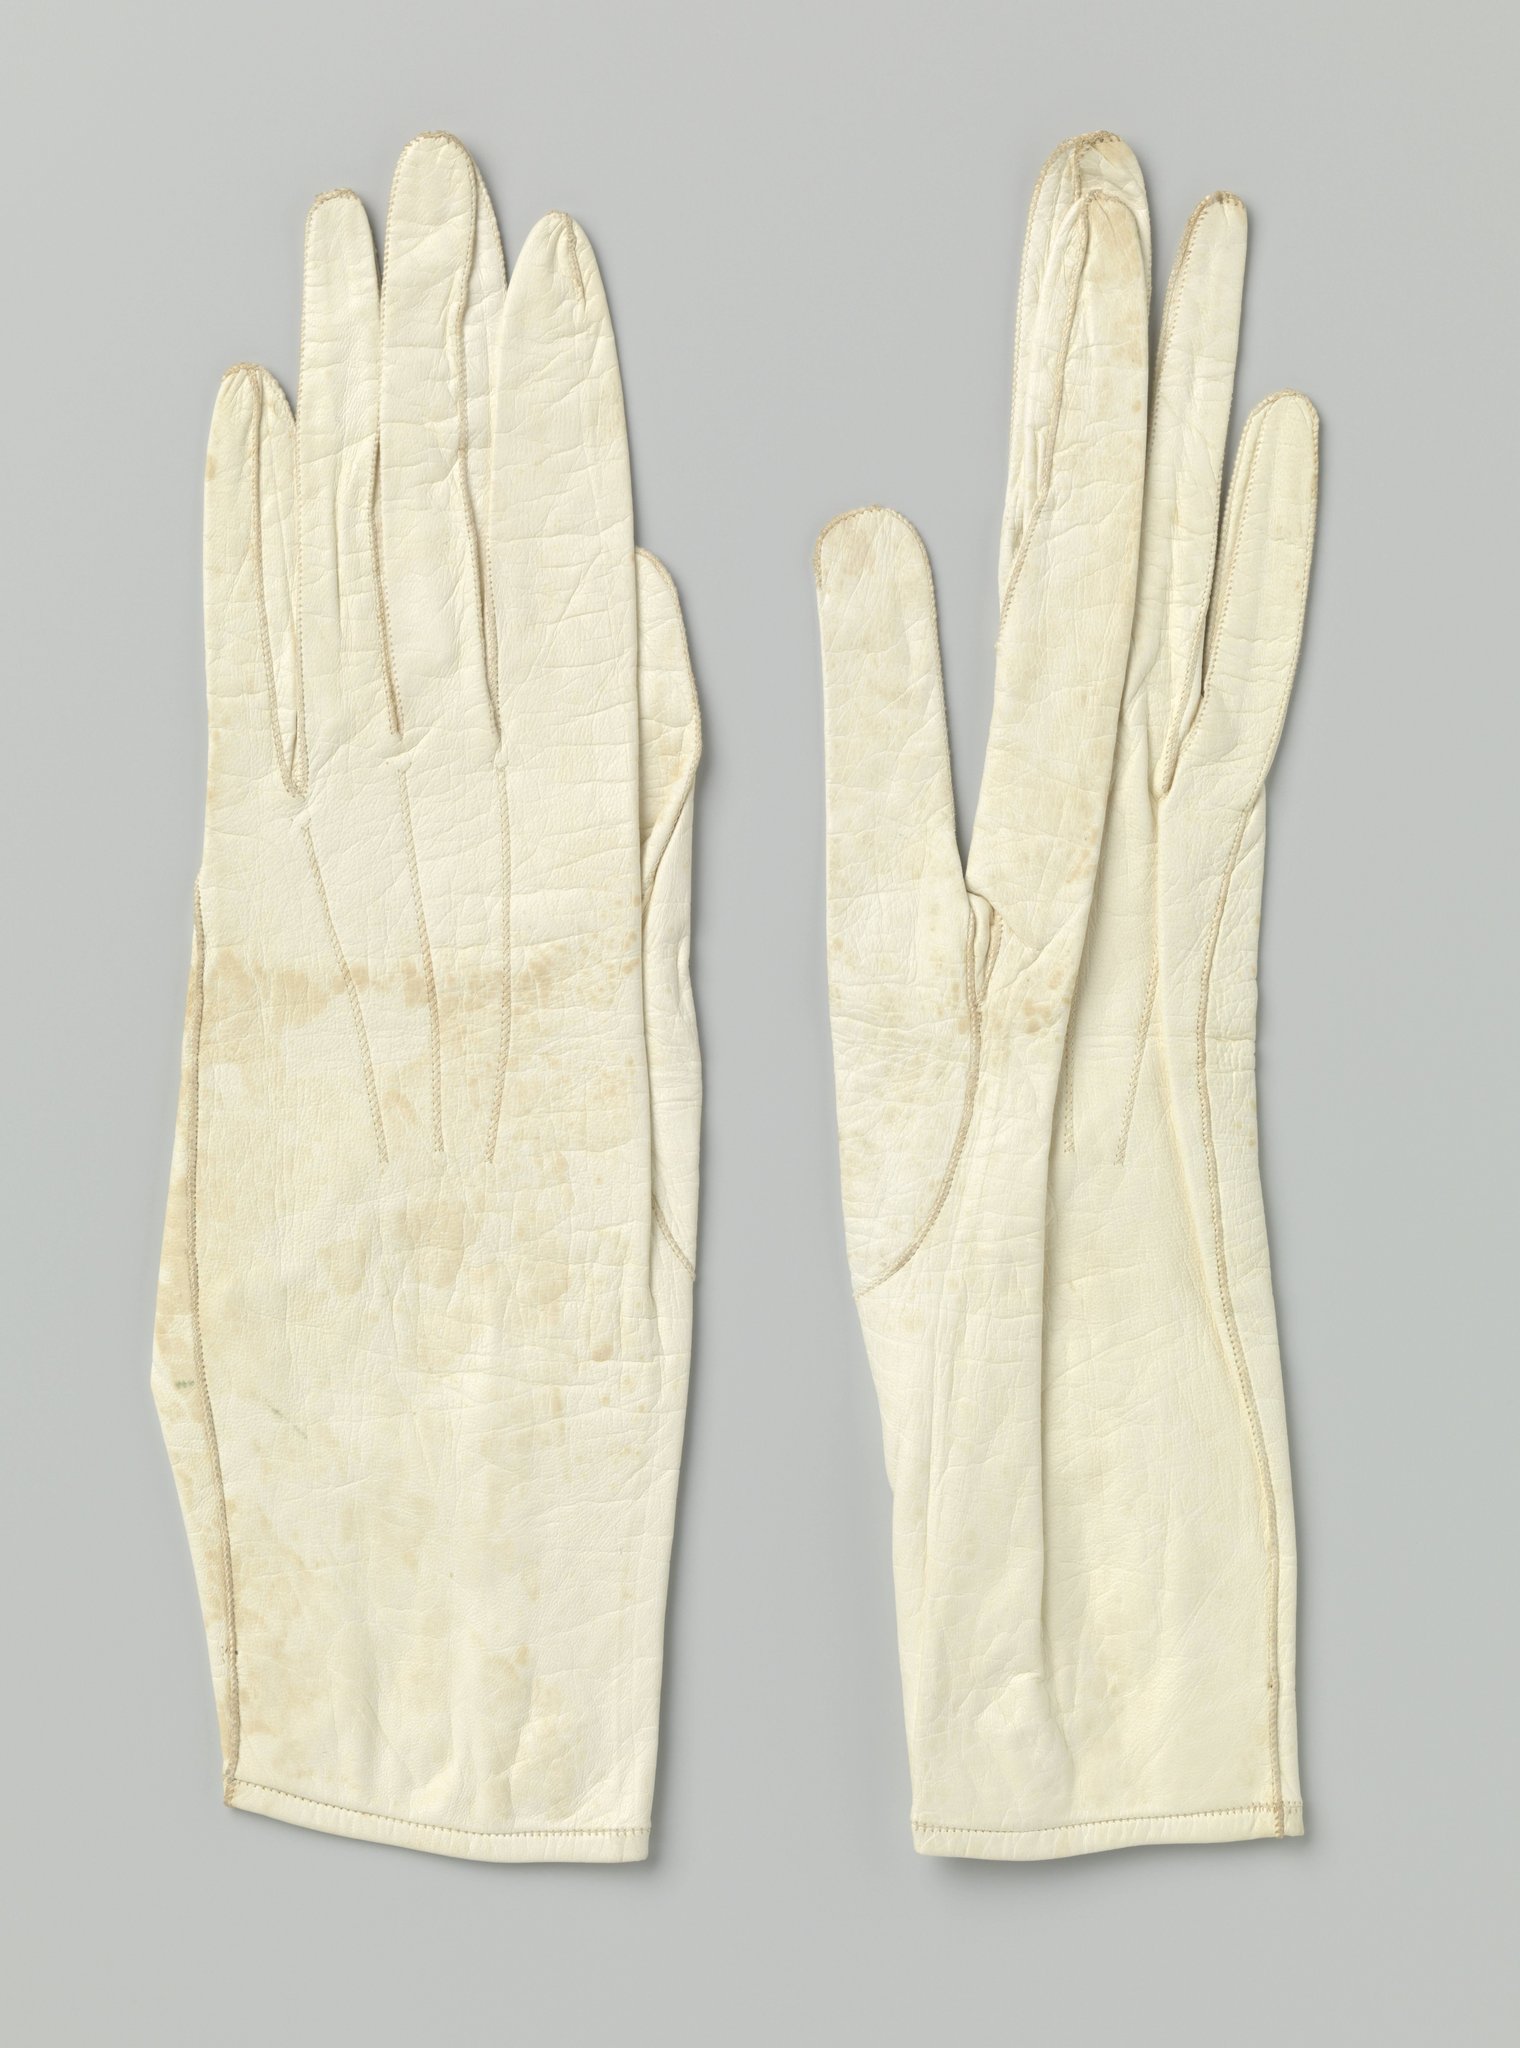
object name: womenswear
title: Handschoen van glacéleer, kort model, sluiting met drie knopen van parelmoer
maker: m. laimböck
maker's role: modehuis, modewarenhuis, modewinkel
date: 1900-1925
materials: mother of pearl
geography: netherlands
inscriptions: stamp: ‘tekst’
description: Linker handschoen van glacéleer. Bij de pols een split met drie parelmoeren knoopjes. Op de hand drie gestikte lijnen.